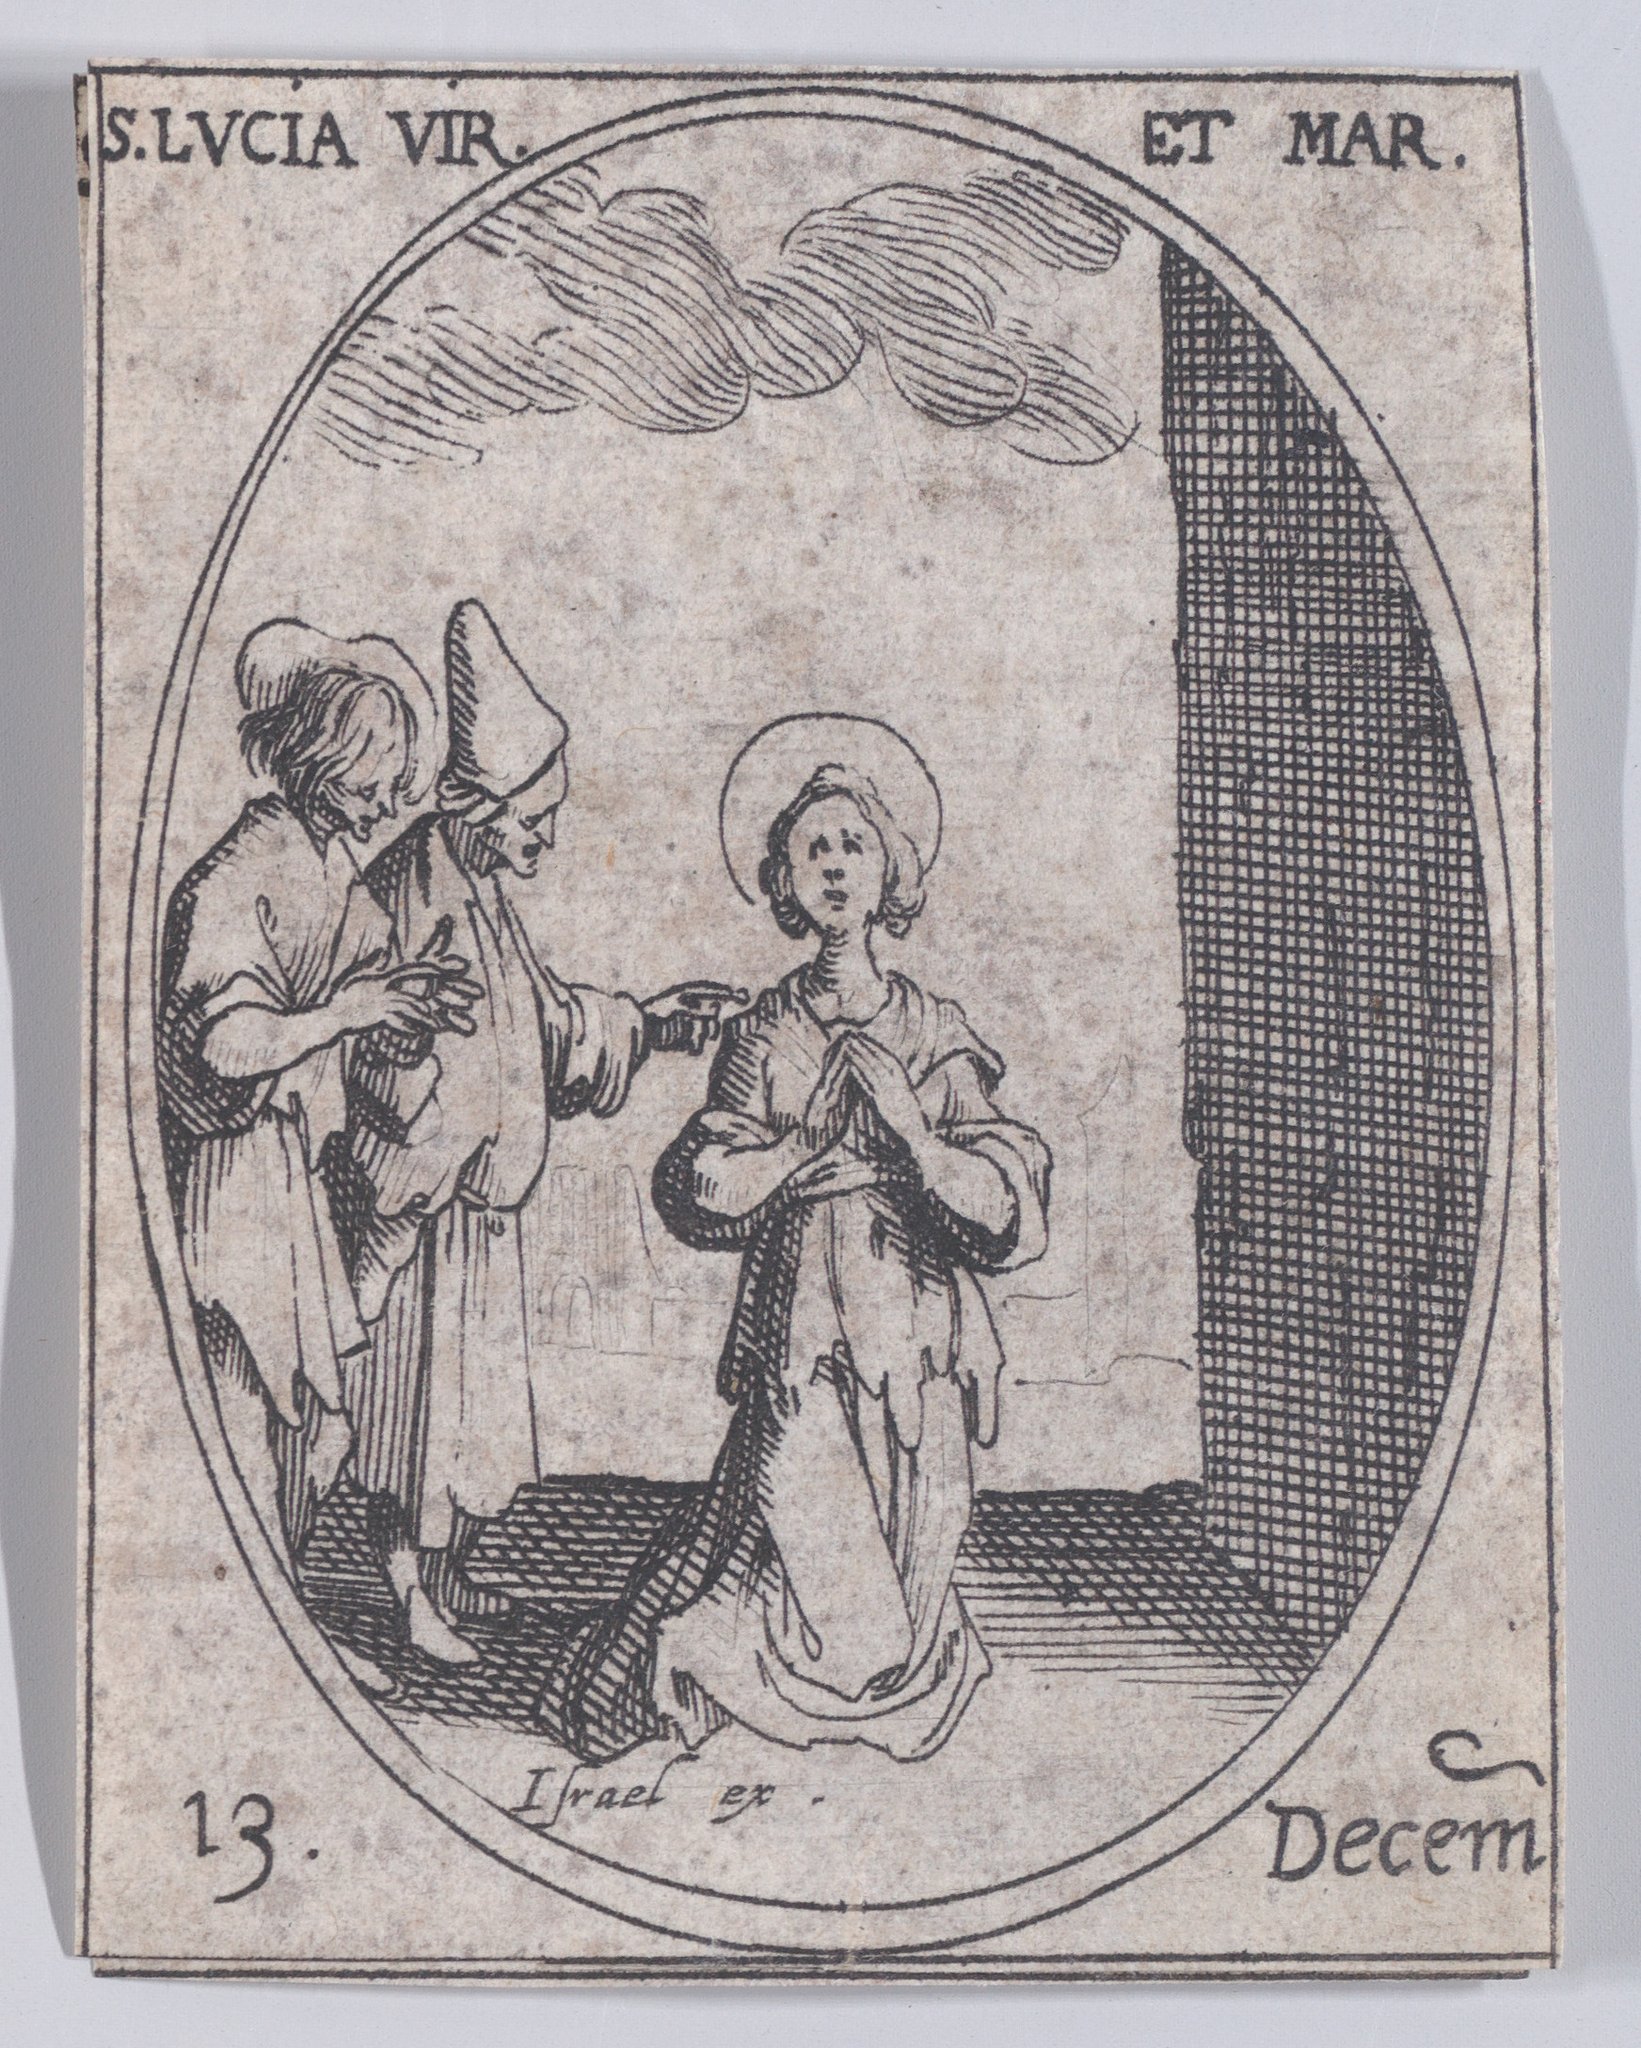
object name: print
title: Ste. Lucie, vierge et martyre (St. Lucy, Virgin and Martyr), December 13th, from "Les Images De Tous Les Saincts et Saintes de L'Année" (Images of All of the Saints and Religious Events of the Year)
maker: jacques callot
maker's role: artist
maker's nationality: french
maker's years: 1592-1635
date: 1636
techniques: etching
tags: men,women,saints